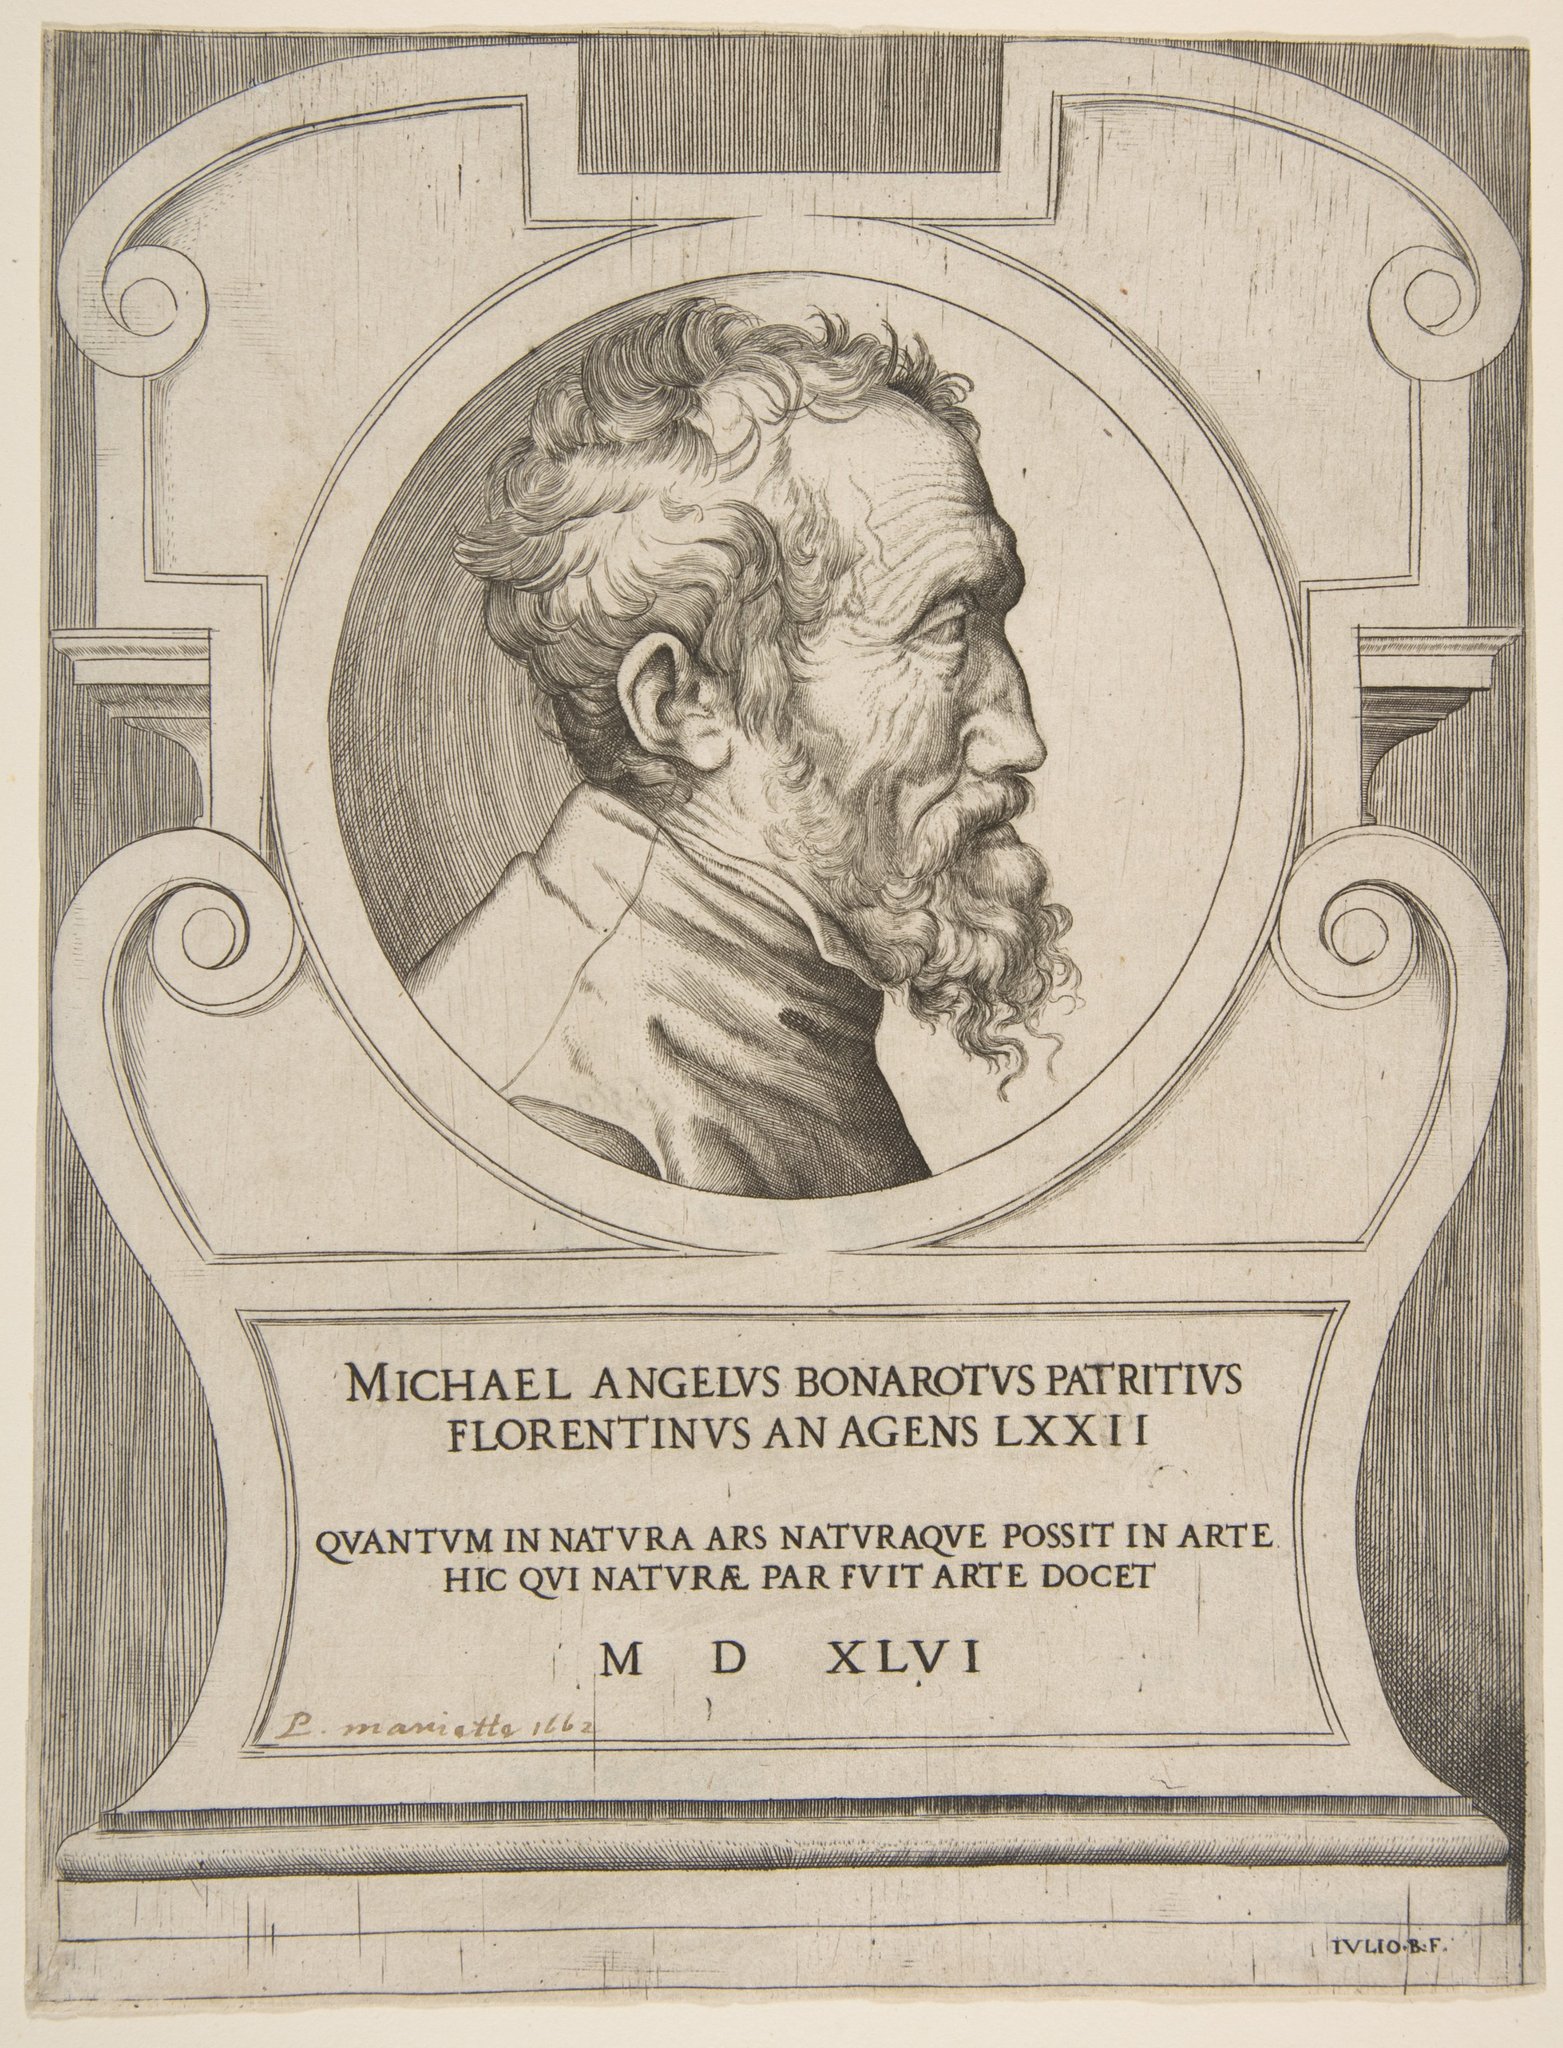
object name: print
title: Bust portrait of Michelangelo facing right, set within a cartouche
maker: giulio bonasone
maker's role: artist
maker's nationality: italian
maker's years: 1510-1576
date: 1546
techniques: engraving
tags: men,profiles